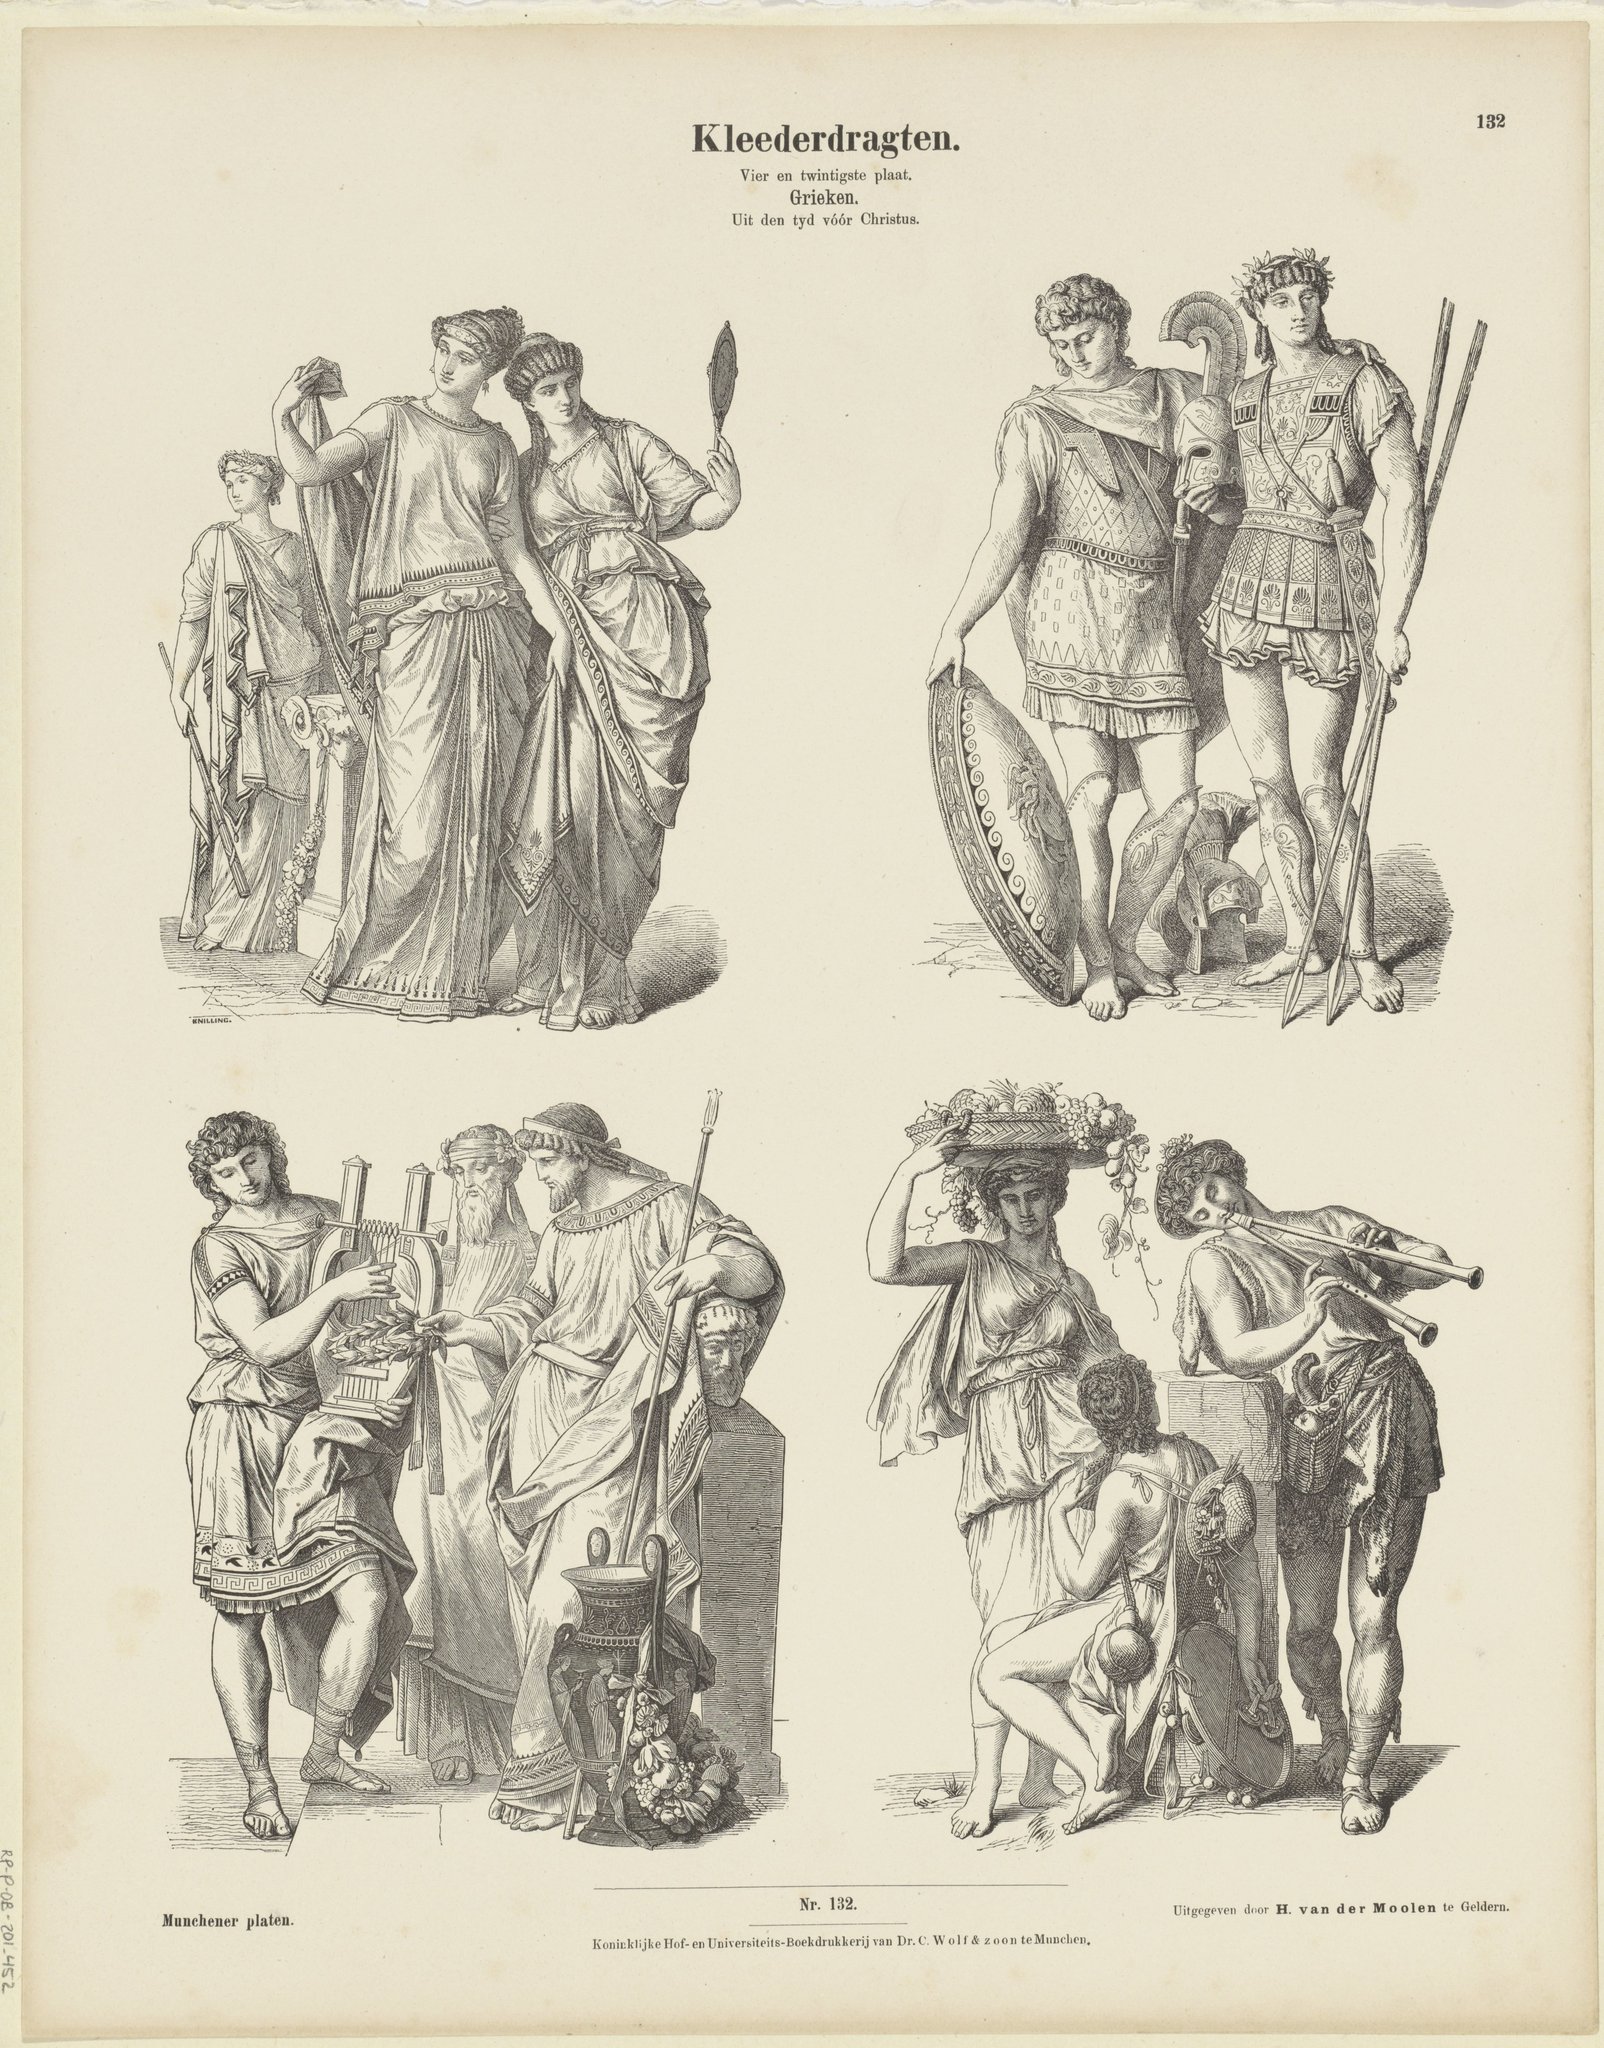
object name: popular print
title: Kleederdragten / Vier en twintigste plaat. / Grieken. / Uit den tyd vóór Christus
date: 1843-1920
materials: paper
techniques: letterpress printing, engraving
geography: munich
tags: historical costume, folk costume, regional costume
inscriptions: collector's mark: Lugt 2760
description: Nederlandse editie van een prent uit de reeks "Munchener platen" uitgegeven door K. Braun & Fr. Schneider te München met het adres van wederverkoper Hermann van der Moolen.